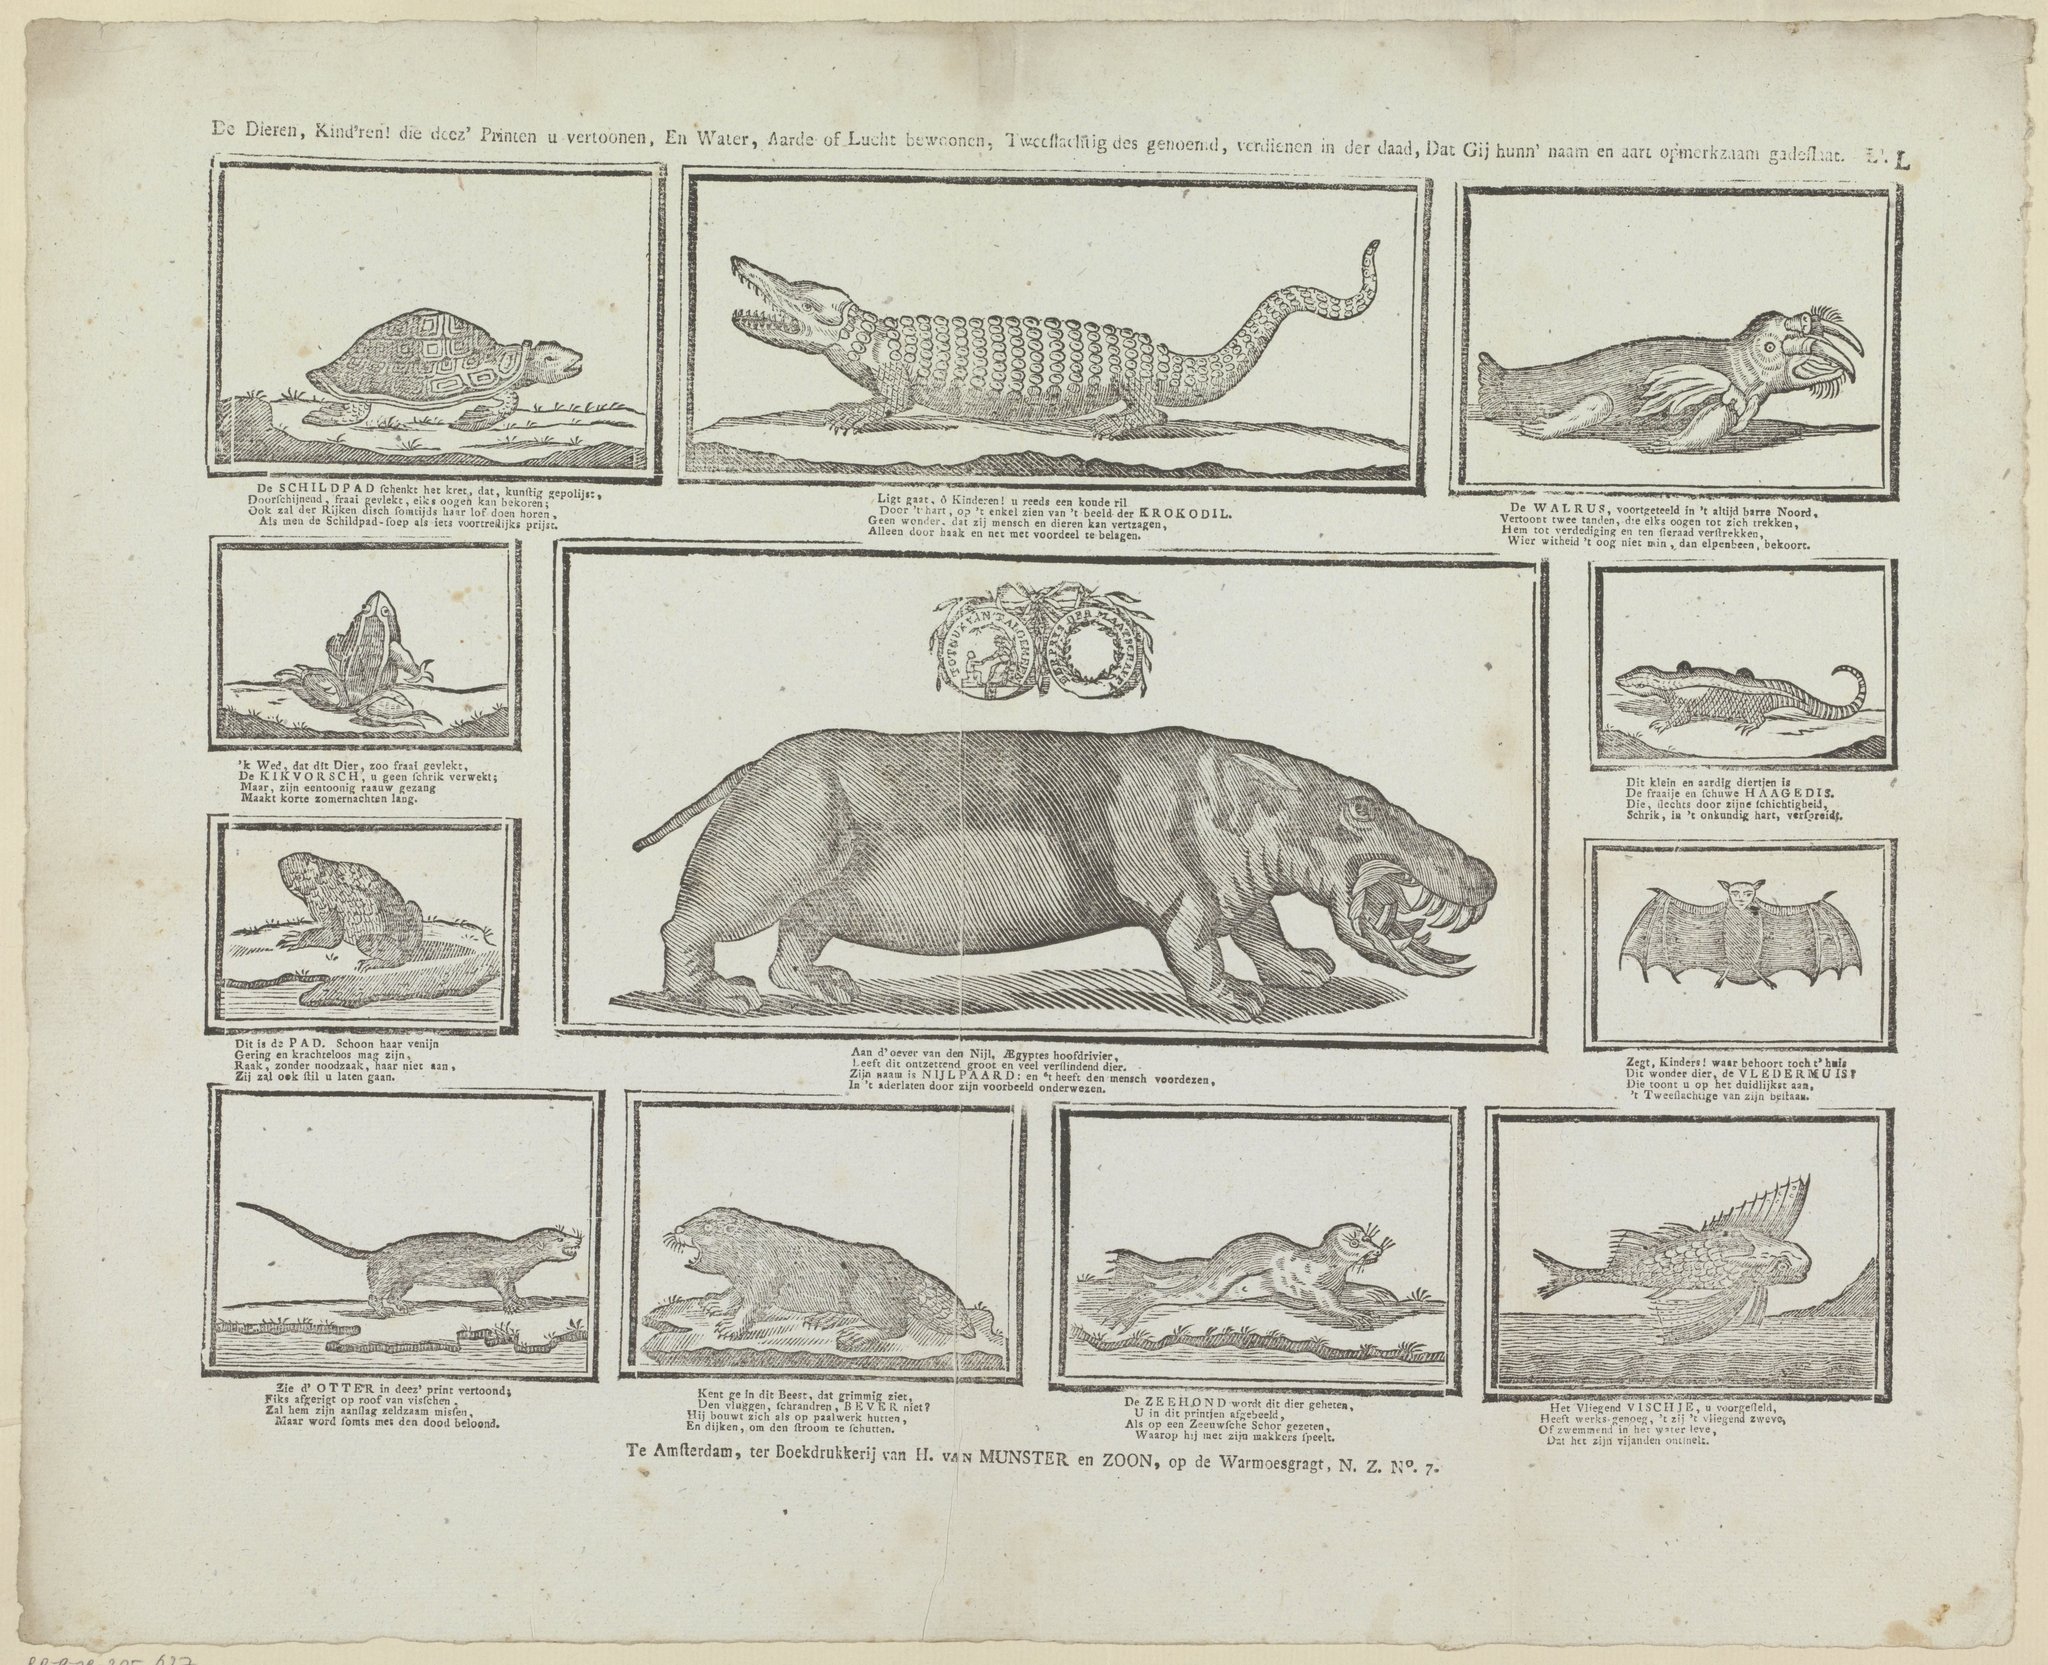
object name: print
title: De dieren, kind'ren! die deez' print u vertoonen, En water, aarde of lucht bewoonen, Tweeslachtig des genoemd, verdienen in der daad, Dat gij hunn' naam en aart opmerkzaam gadeslaat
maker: Anonymous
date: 1811-1829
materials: paper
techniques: letterpress printing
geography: netherlands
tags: mammals, amphibians, reptiles, fishes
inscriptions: collector's mark: Lugt 2760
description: Blad met 12 voorstellingen van amfibieën, reptielen, zoogdieren en een vis. In het midden het zegel van de Maatschappij tot Nut van 't Algemeen. Onder elke afbeelding een vierregelig vers met de naam van het dier. Genummerd rechtsboven: L.L.